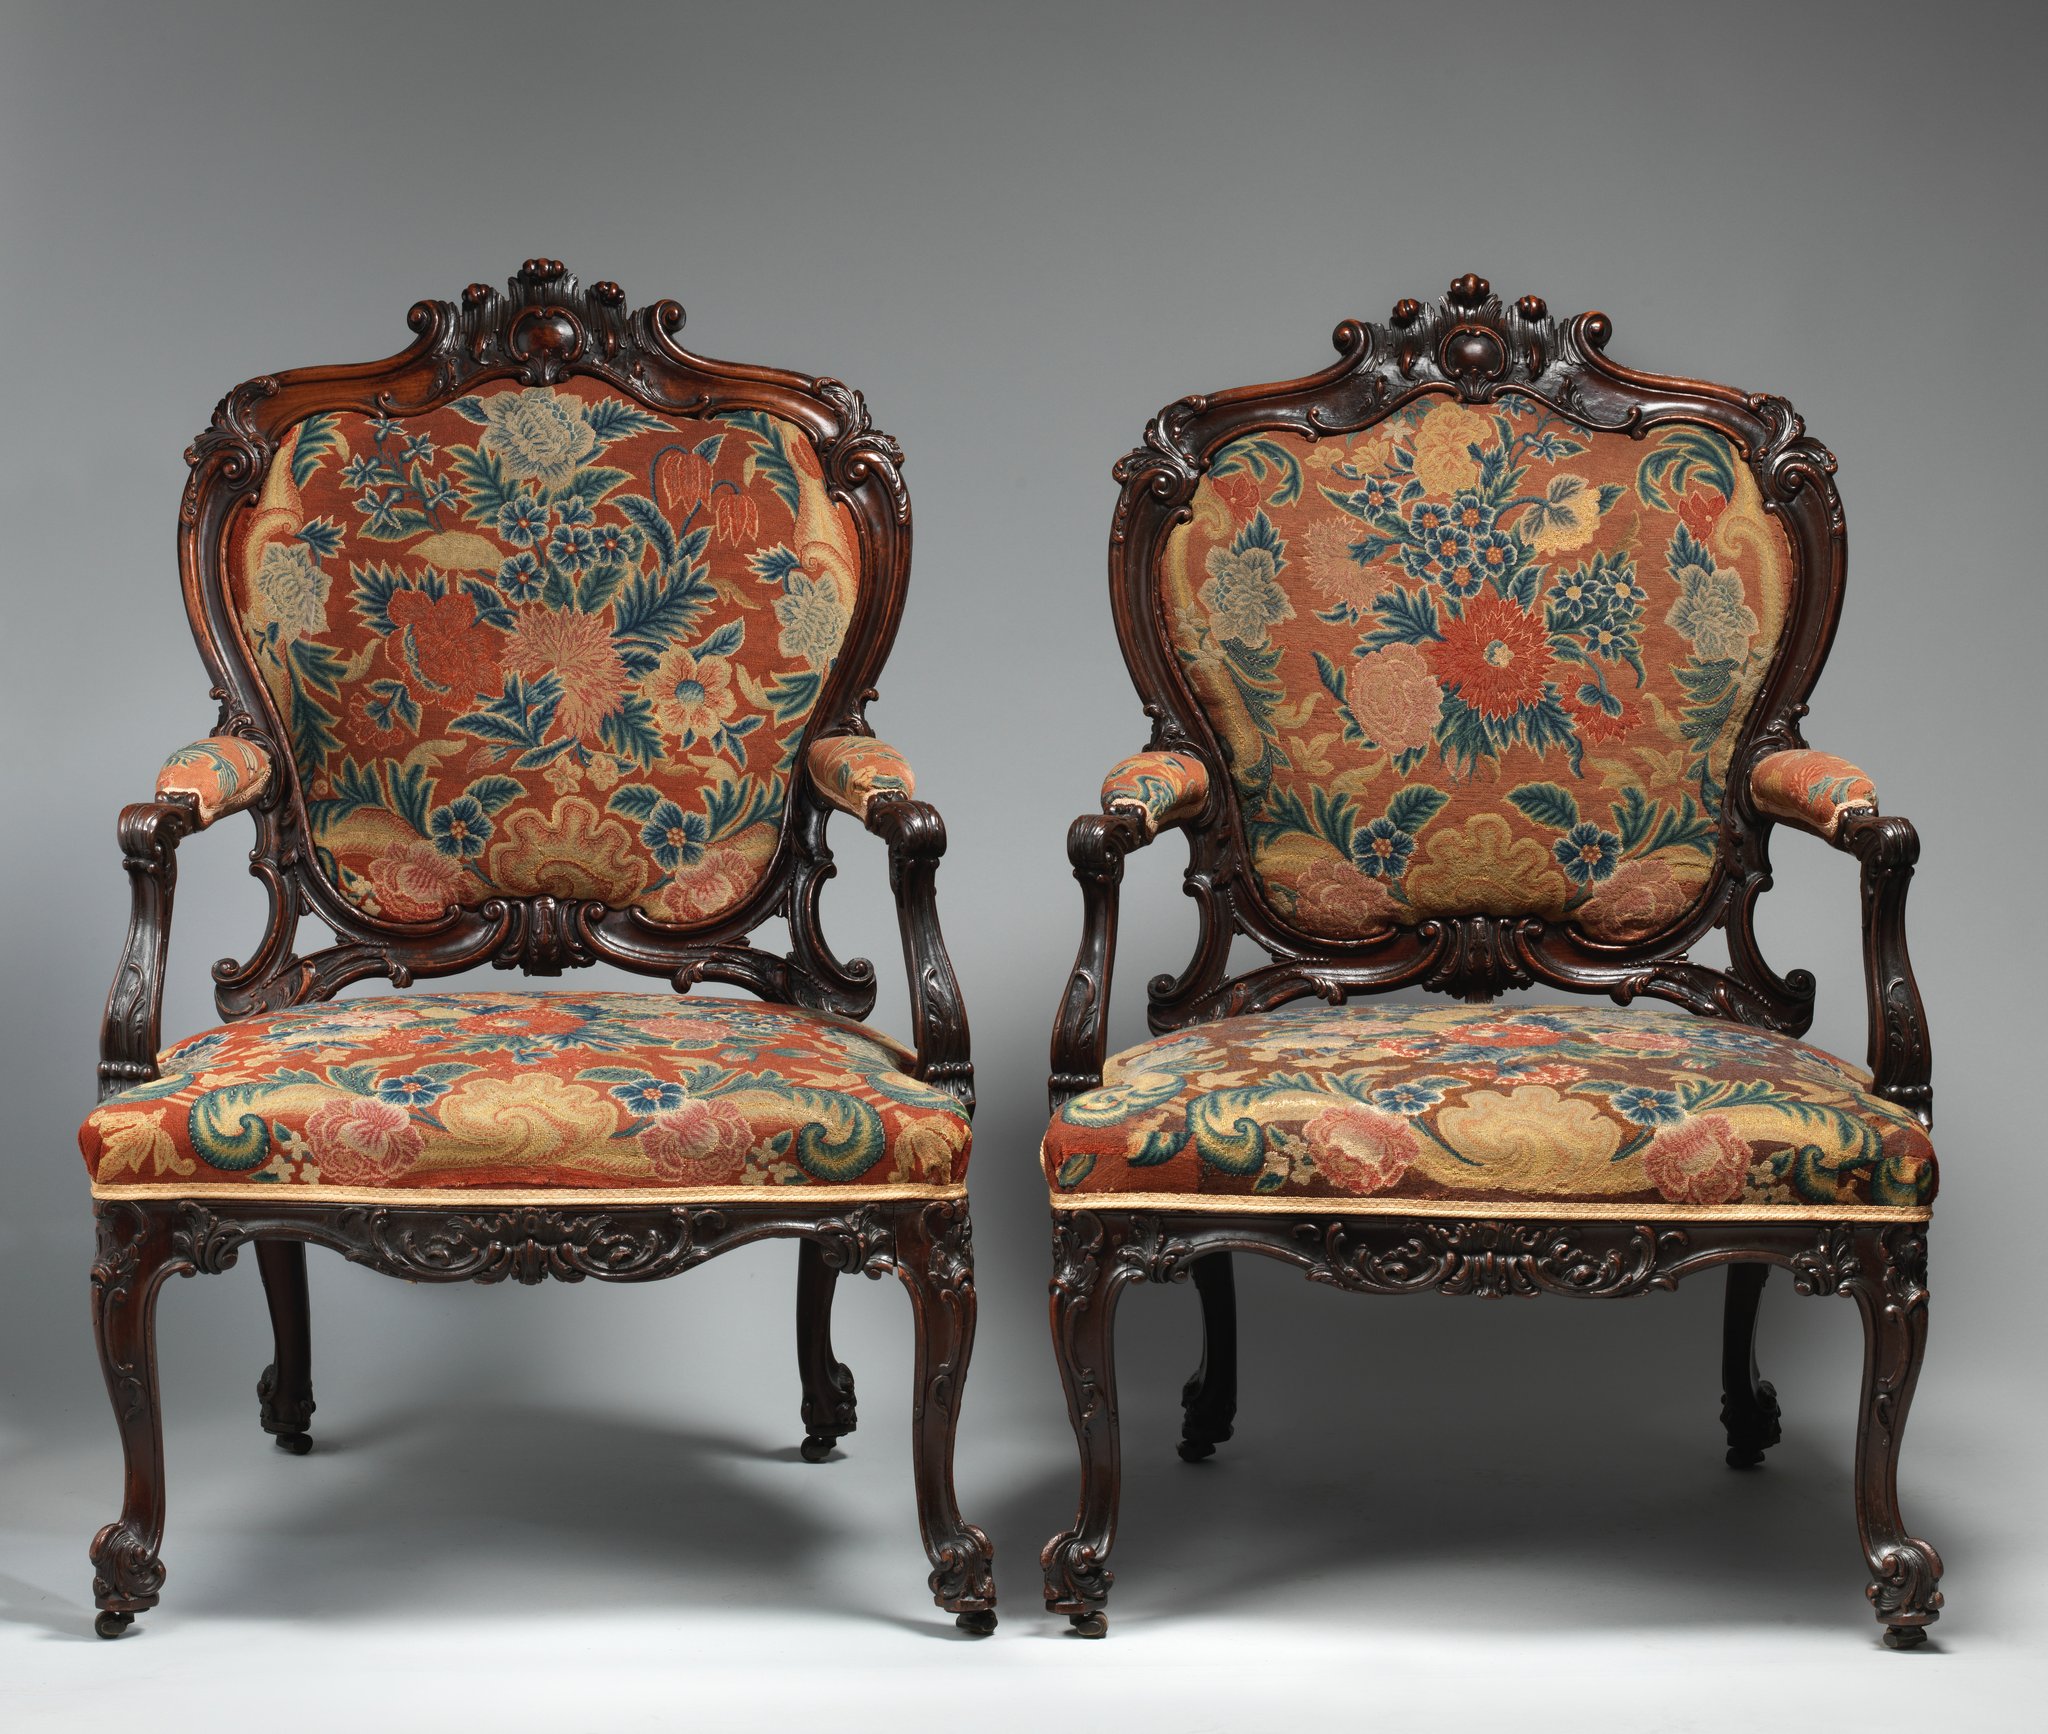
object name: armchair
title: Pair of armchairs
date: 1765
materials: wood